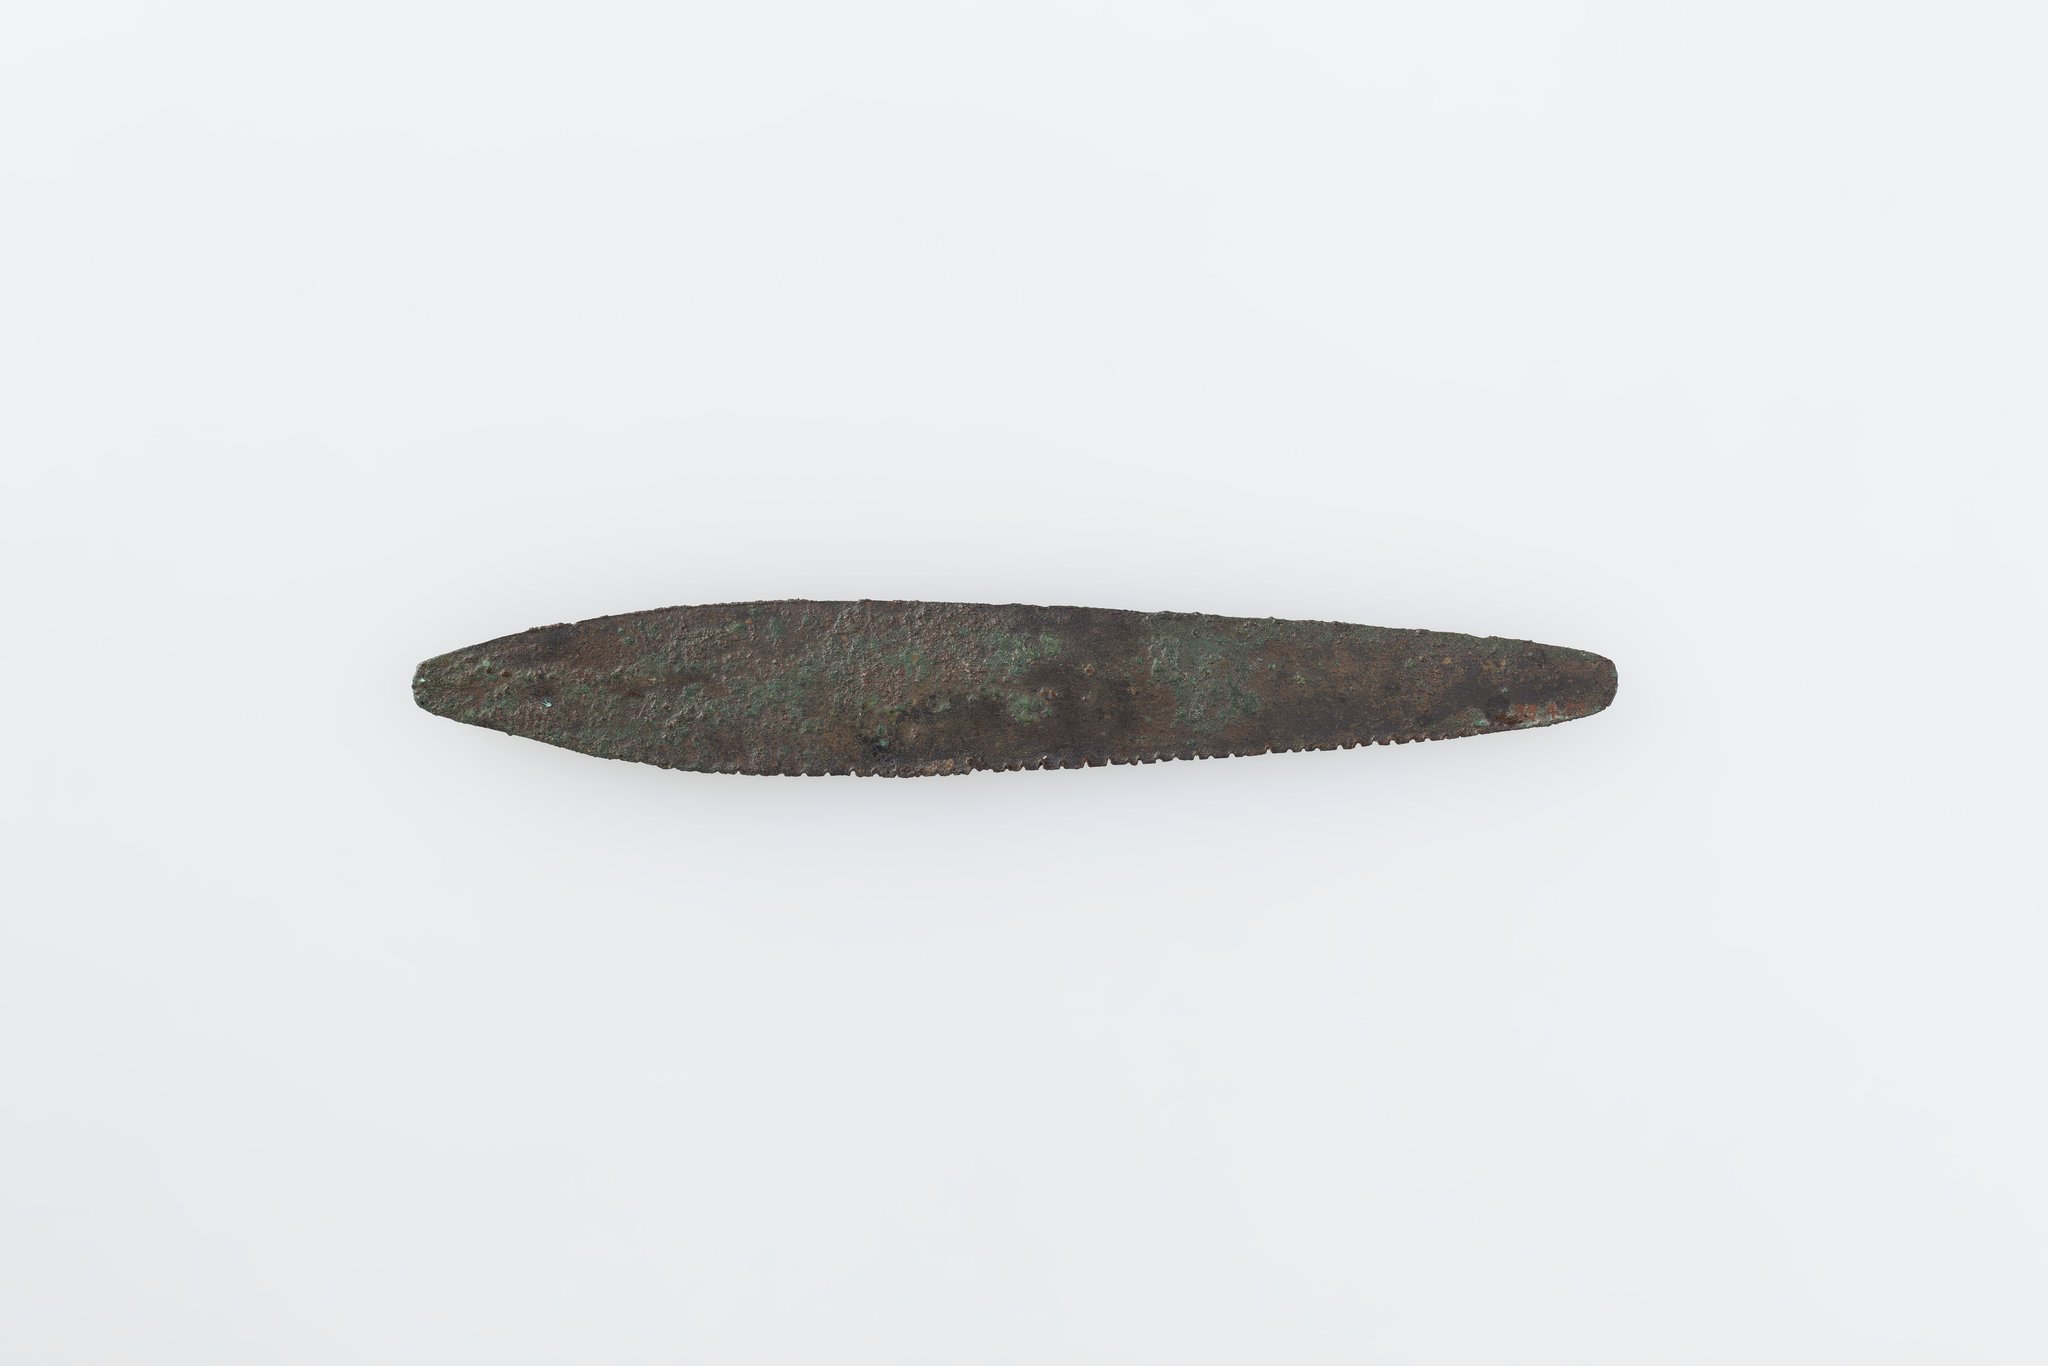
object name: tool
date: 2100-1950 BCE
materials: bronze, copper alloy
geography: egypt